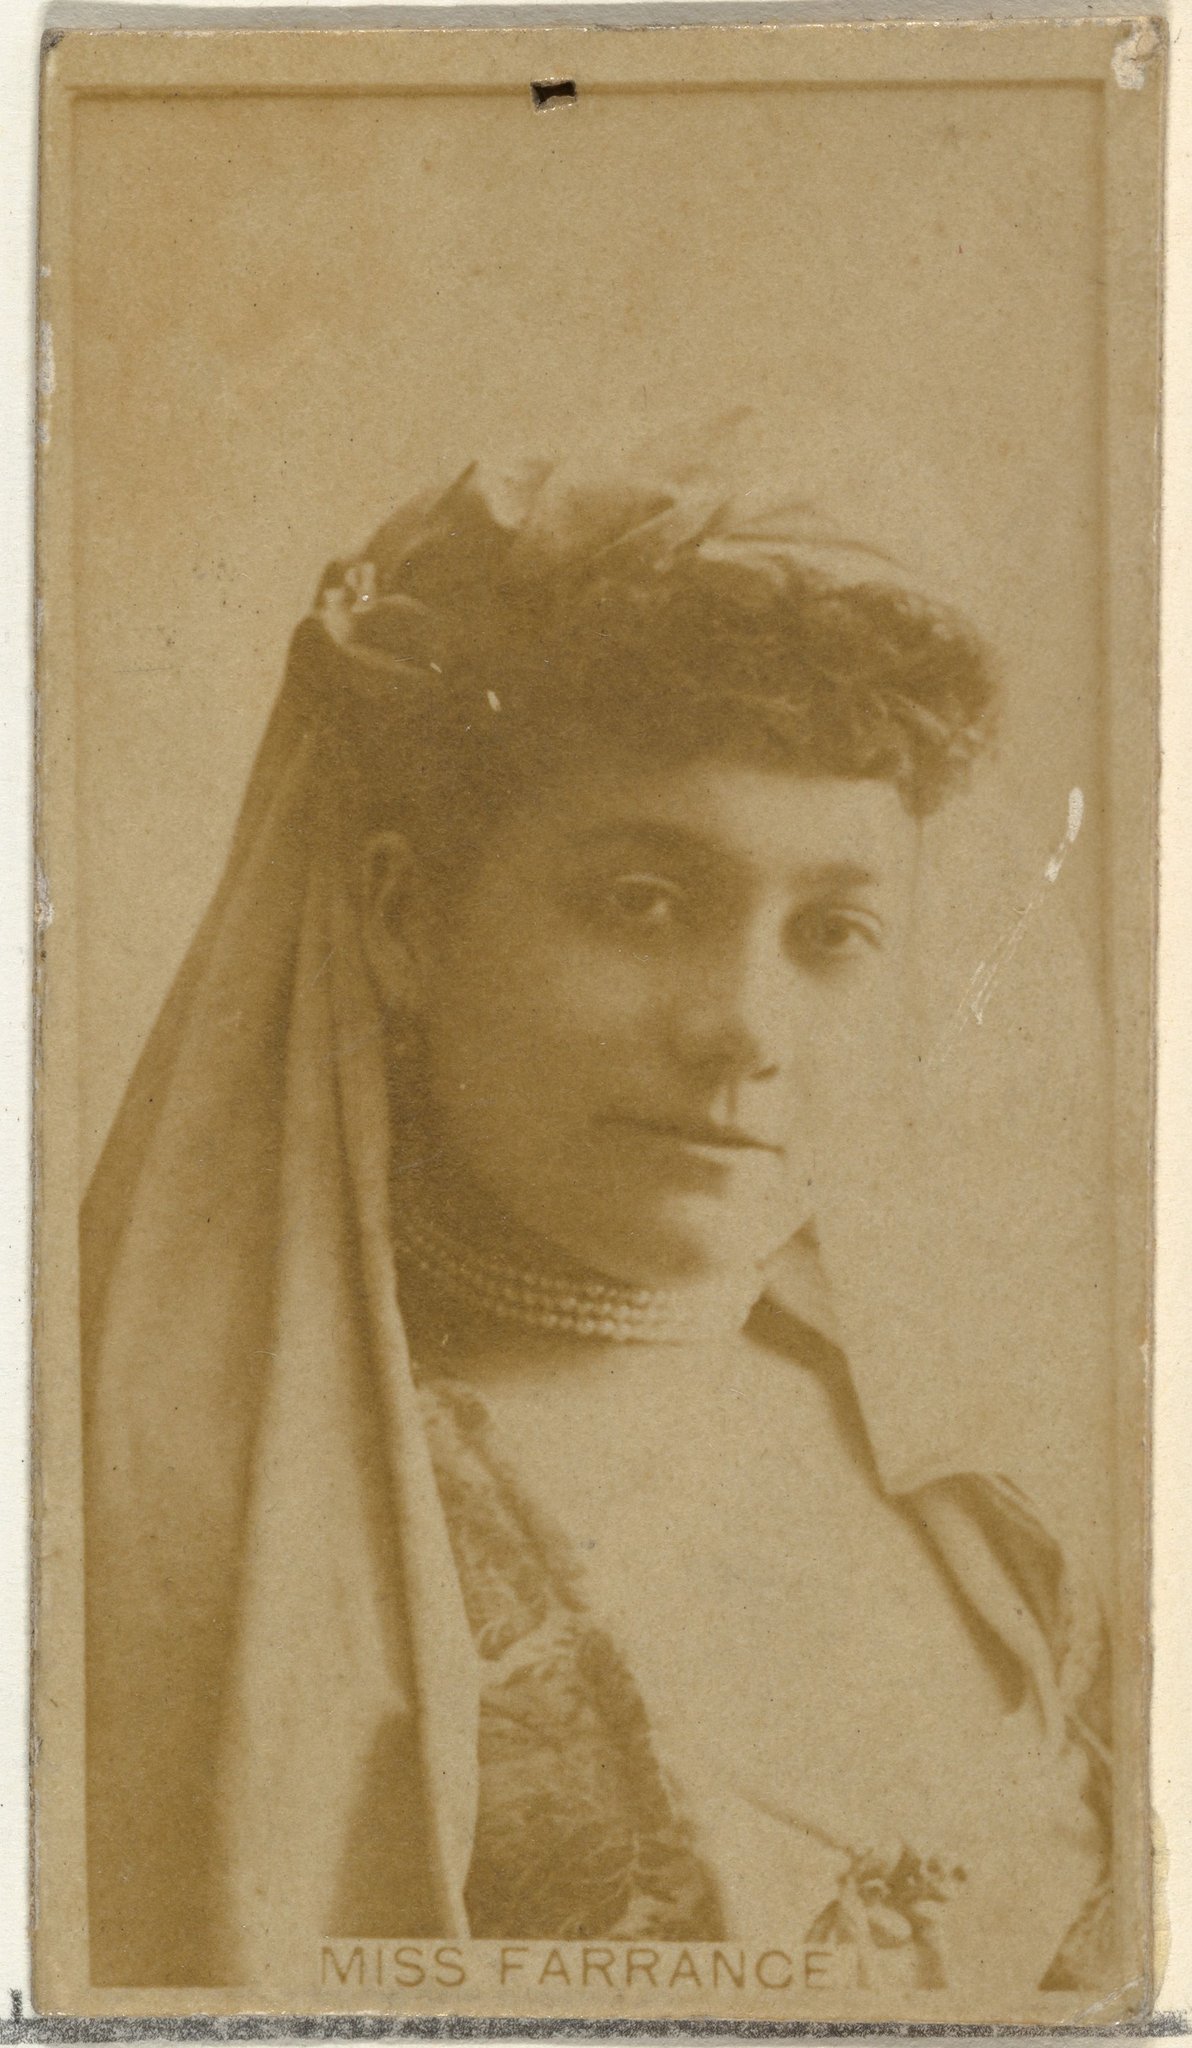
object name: photograph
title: Miss Farrance, from the Actors and Actresses series (N145-8) issued by Duke Sons & Co. to promote Duke Cigarettes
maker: w. duke, sons & co.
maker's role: publisher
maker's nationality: american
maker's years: 1870-1920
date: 1891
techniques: albumen silver print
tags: portraits,women,actresses